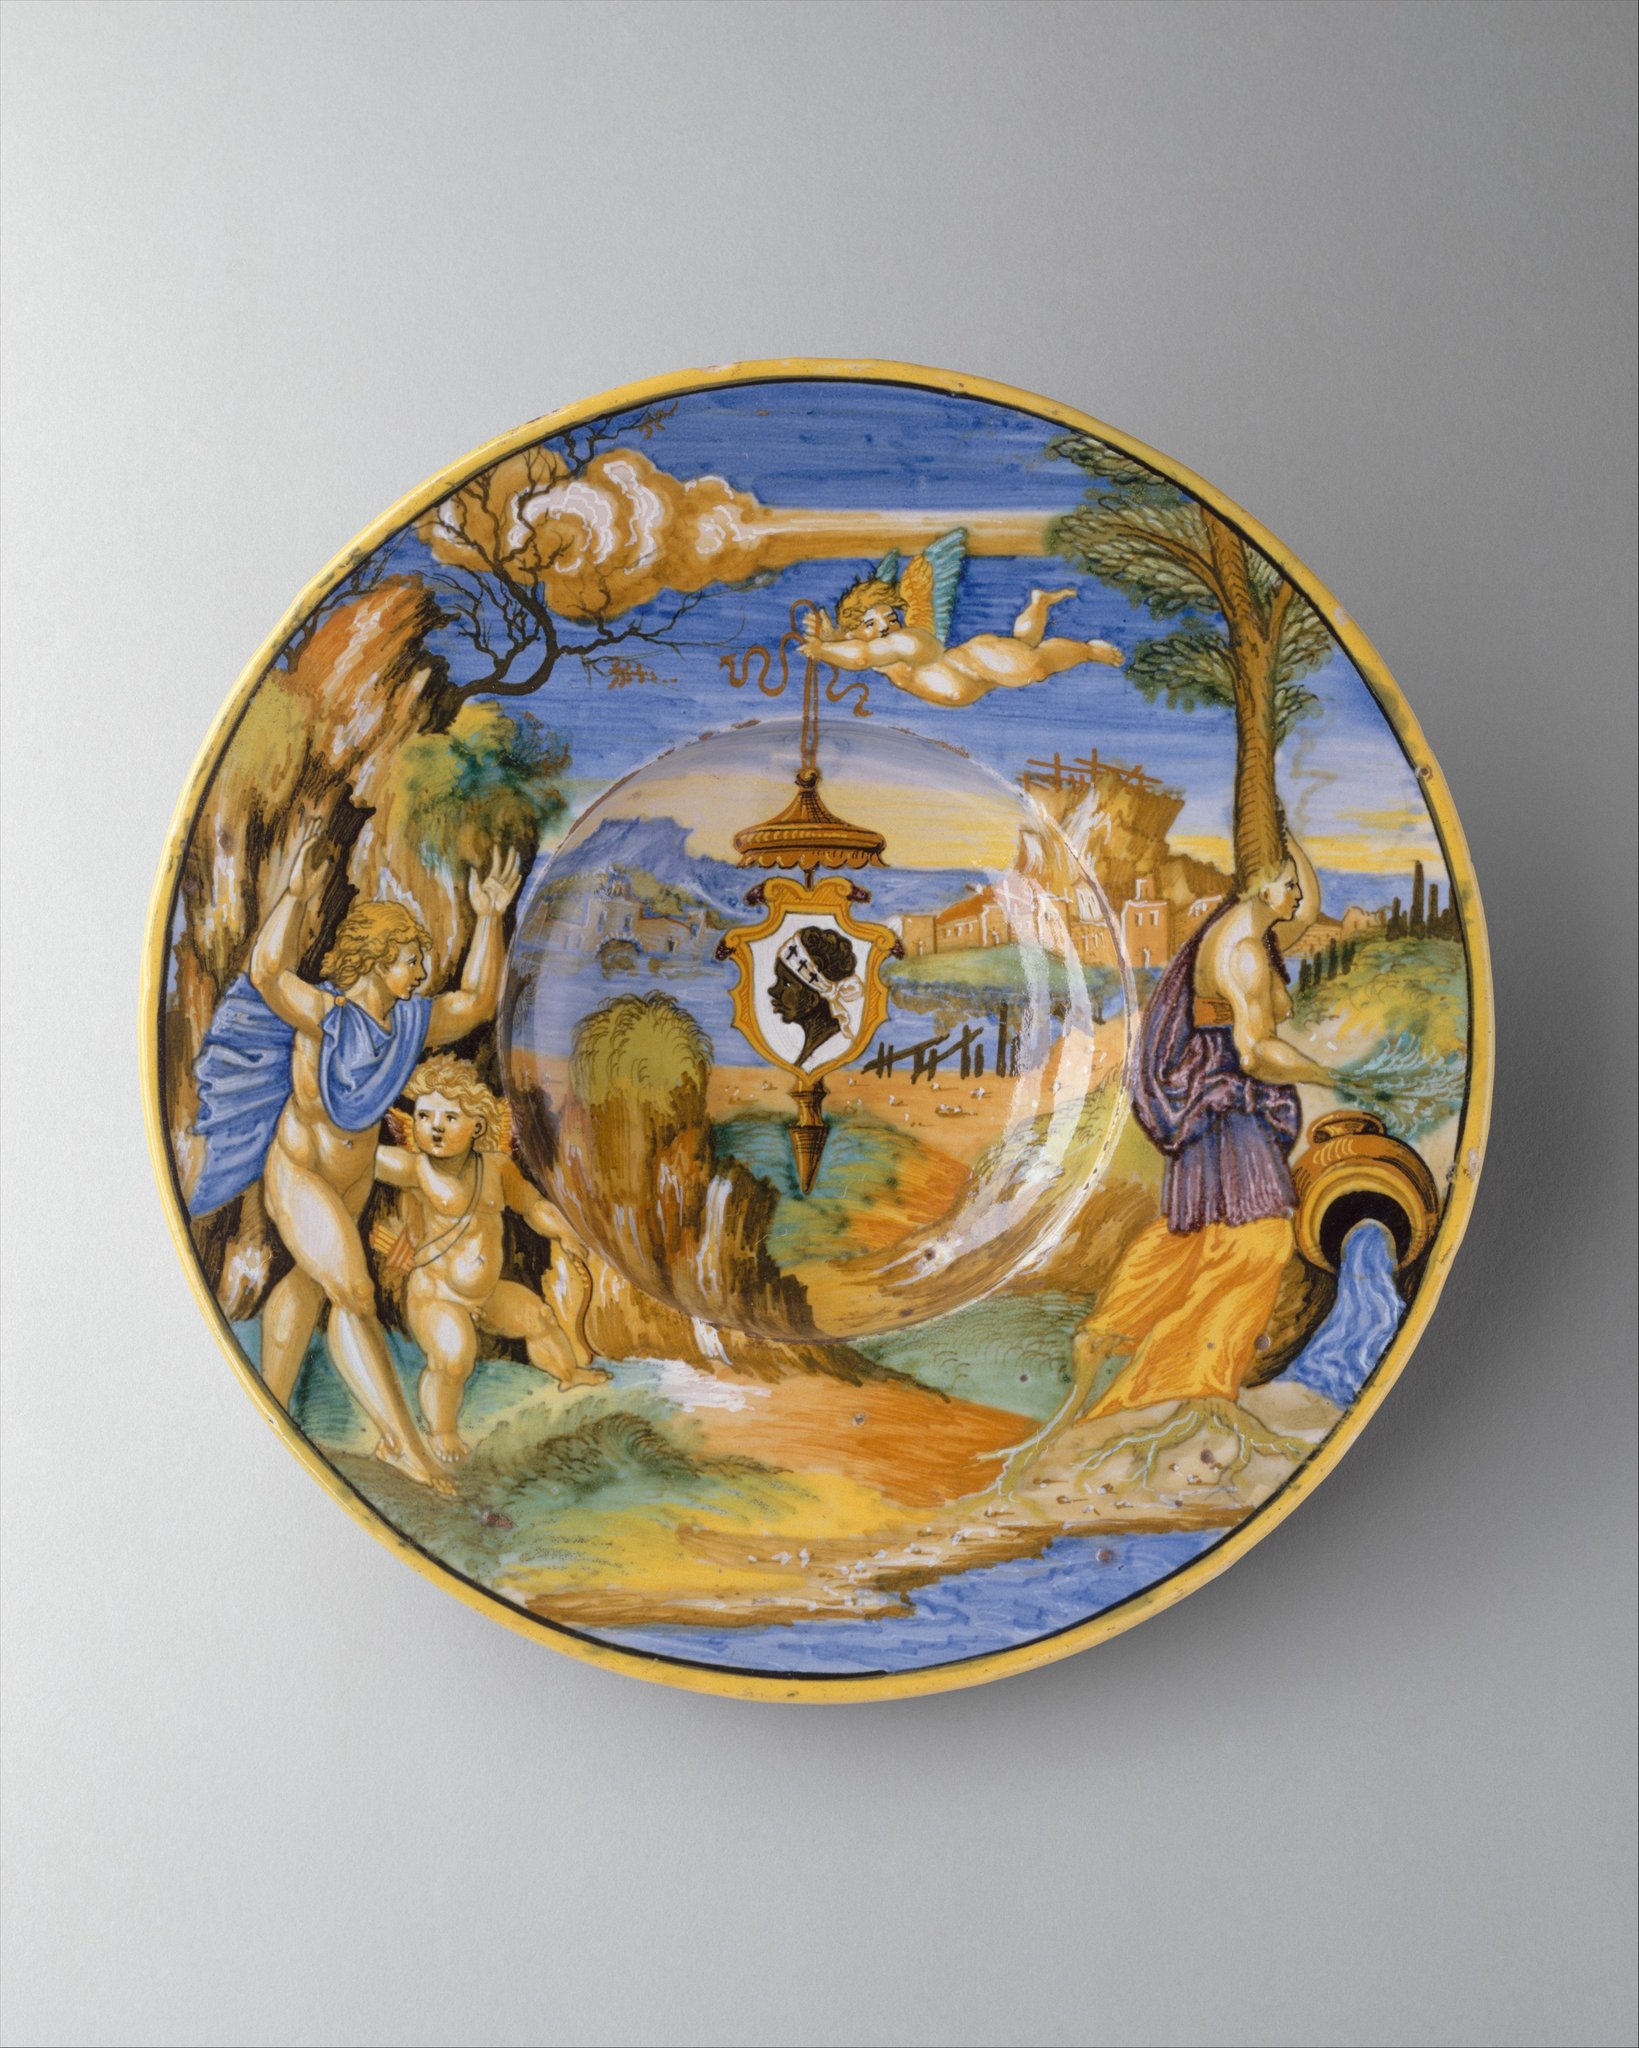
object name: dish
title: Armorial dish: The story of Apollo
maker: francesco xanto avelli da rovigo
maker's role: artist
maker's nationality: italian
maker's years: 1482-1542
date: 1532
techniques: maiolica, glazing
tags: cupid,apollo,coat of arms